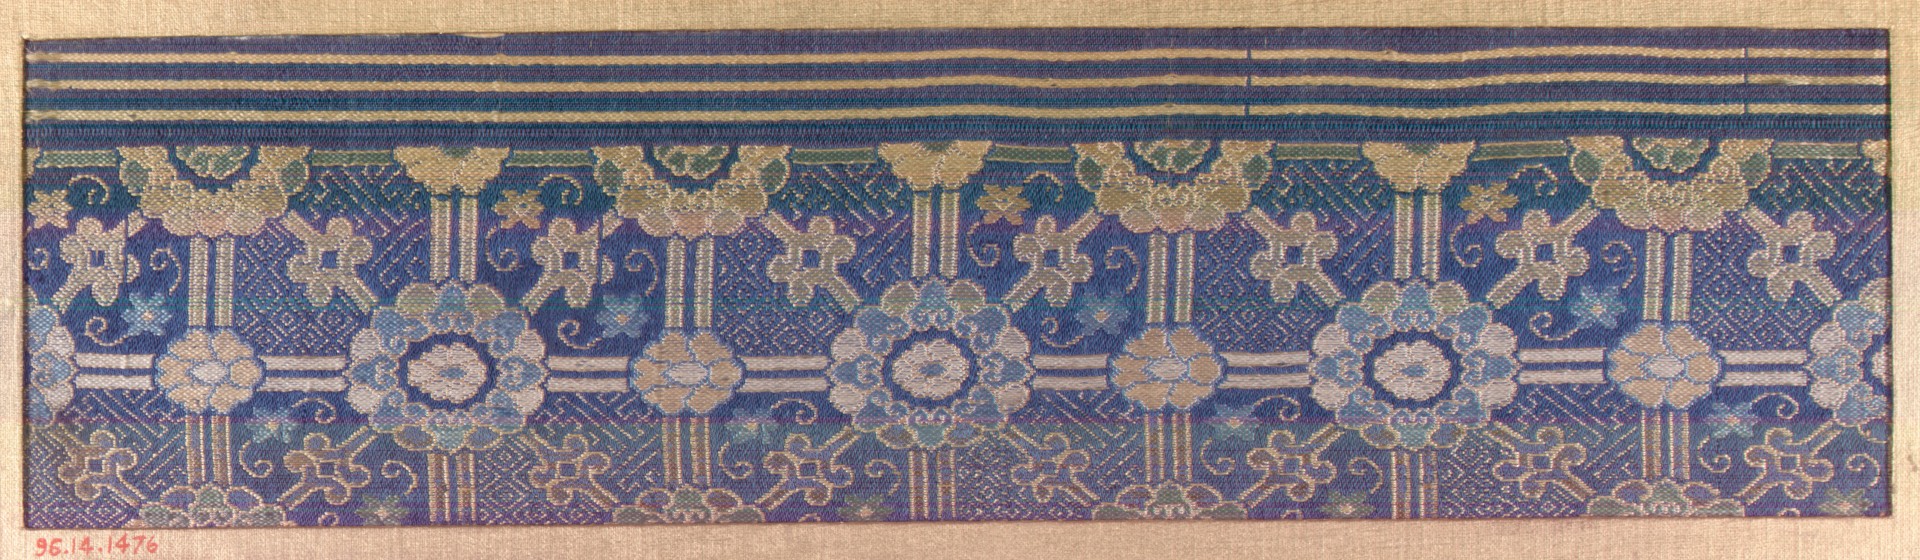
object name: piece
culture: japanese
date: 1701-1900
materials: silk